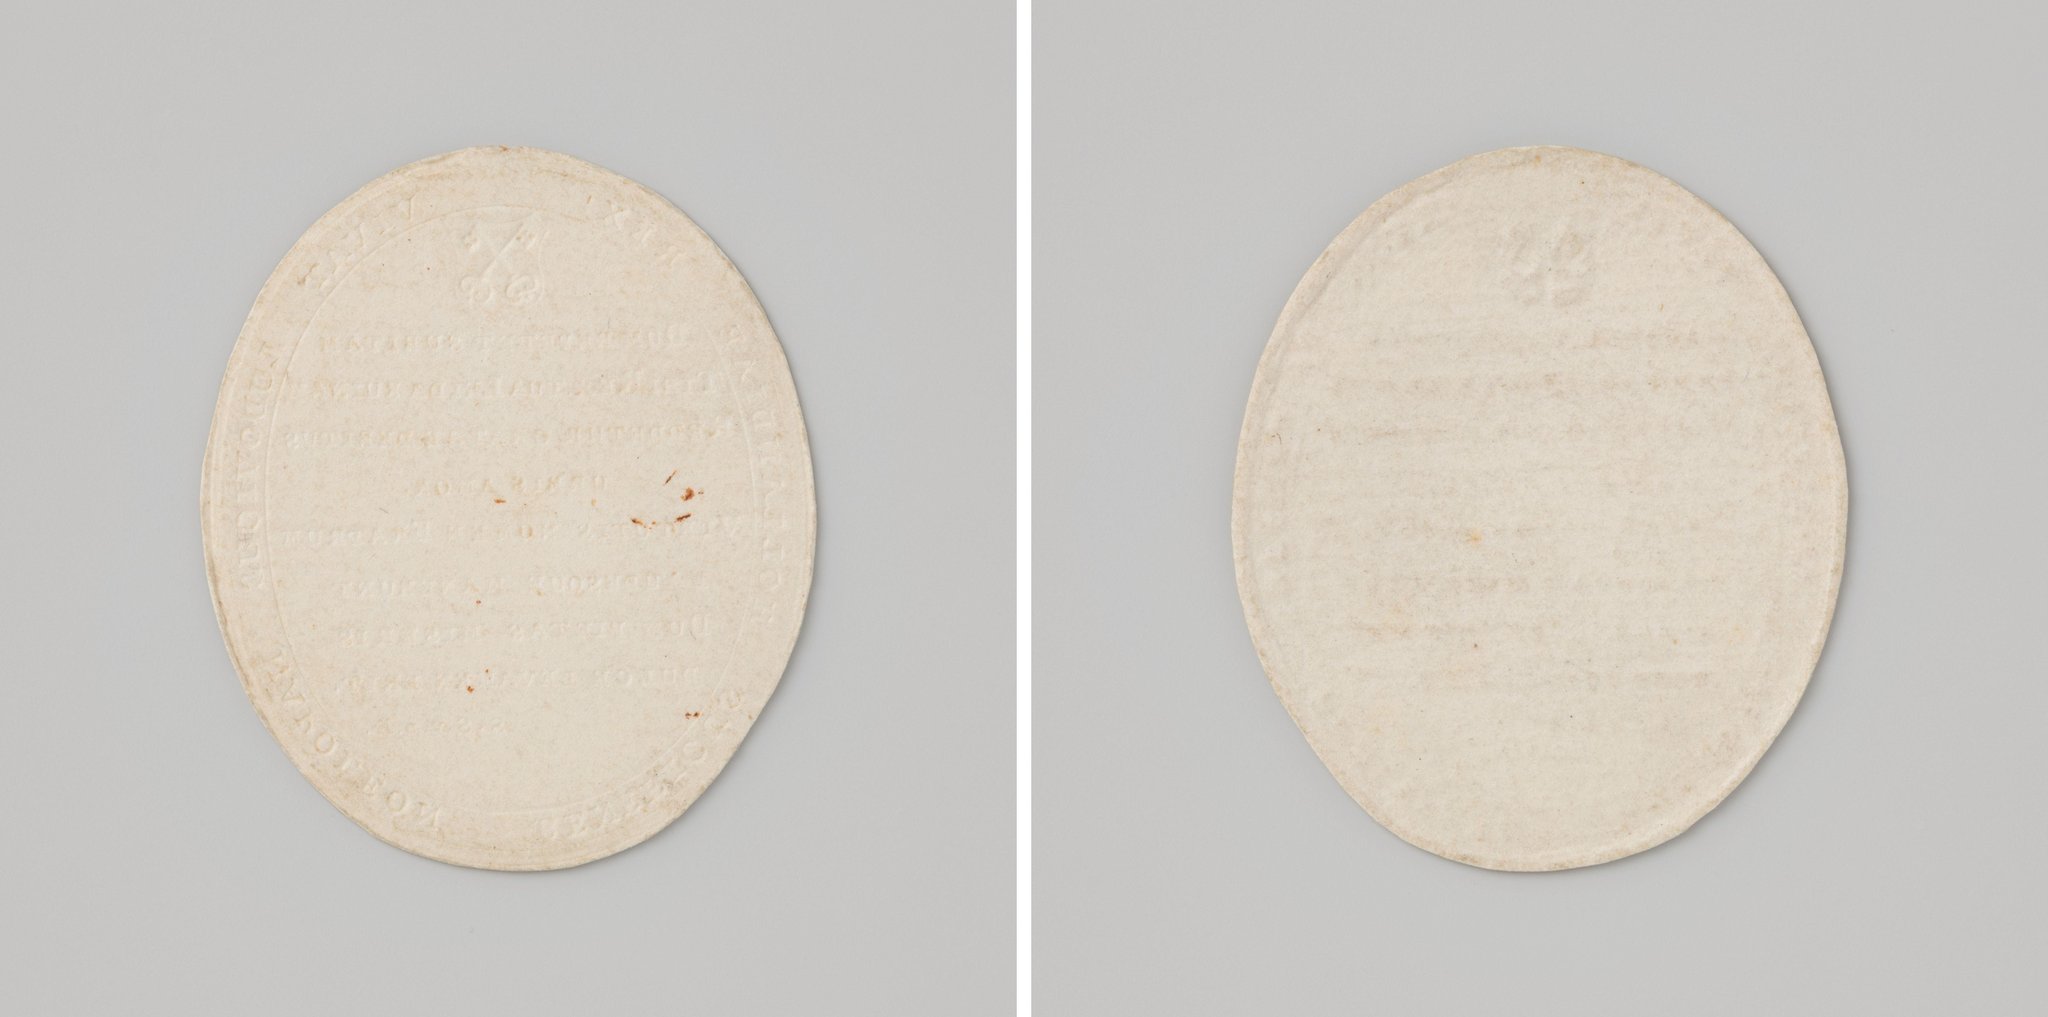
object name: history medal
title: Vijftigjarig bestaan van de loge La Vertu te Leiden 1807 memorerende de buskruitramp, afdruk in karton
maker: Anonymous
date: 1807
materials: cardboard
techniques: pressing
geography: leiden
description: Afdruk in karton van de ovalen penning, met acht regels tekst onder een Leids stadswapenschildje, met omschrift.